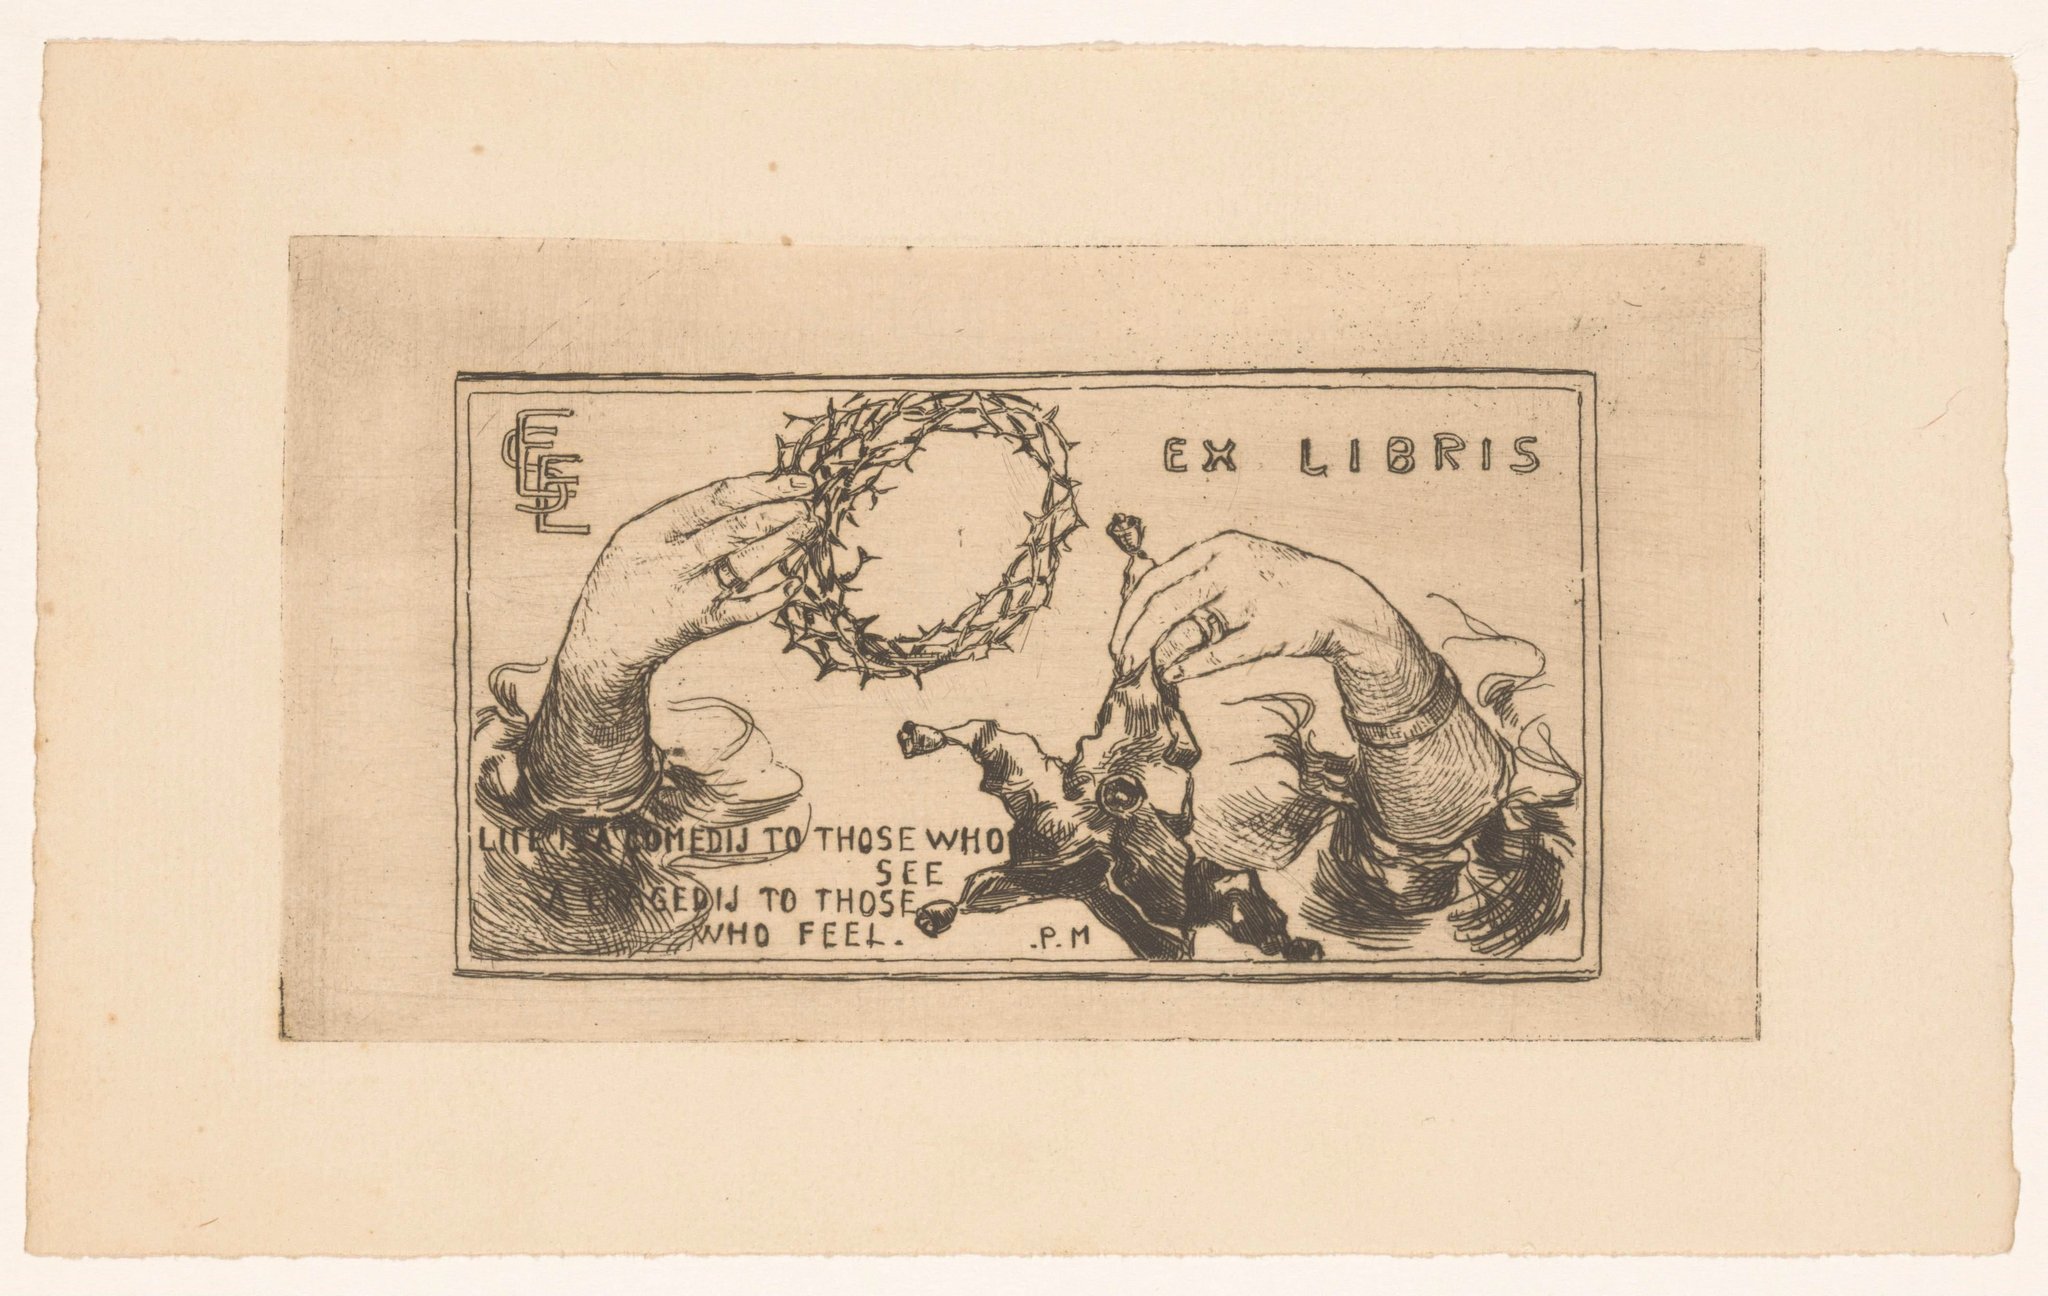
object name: print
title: Ex libris van Eva Emmelina Seelig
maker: piet mondriaan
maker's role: print maker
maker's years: 1872-1944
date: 1905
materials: paper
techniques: etching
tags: amsterdam, painter, hand, head-gear: cap, crown of thorns ~ instruments of the passion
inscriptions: collector's mark: Lugt 2228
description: Links een hand die een doornenkroon vasthoudt; rechts een hand met een narrenkap. Onderaan de tekst: 'Life is a comedy to those who/ see/ a tragedy to those/ who feel.'